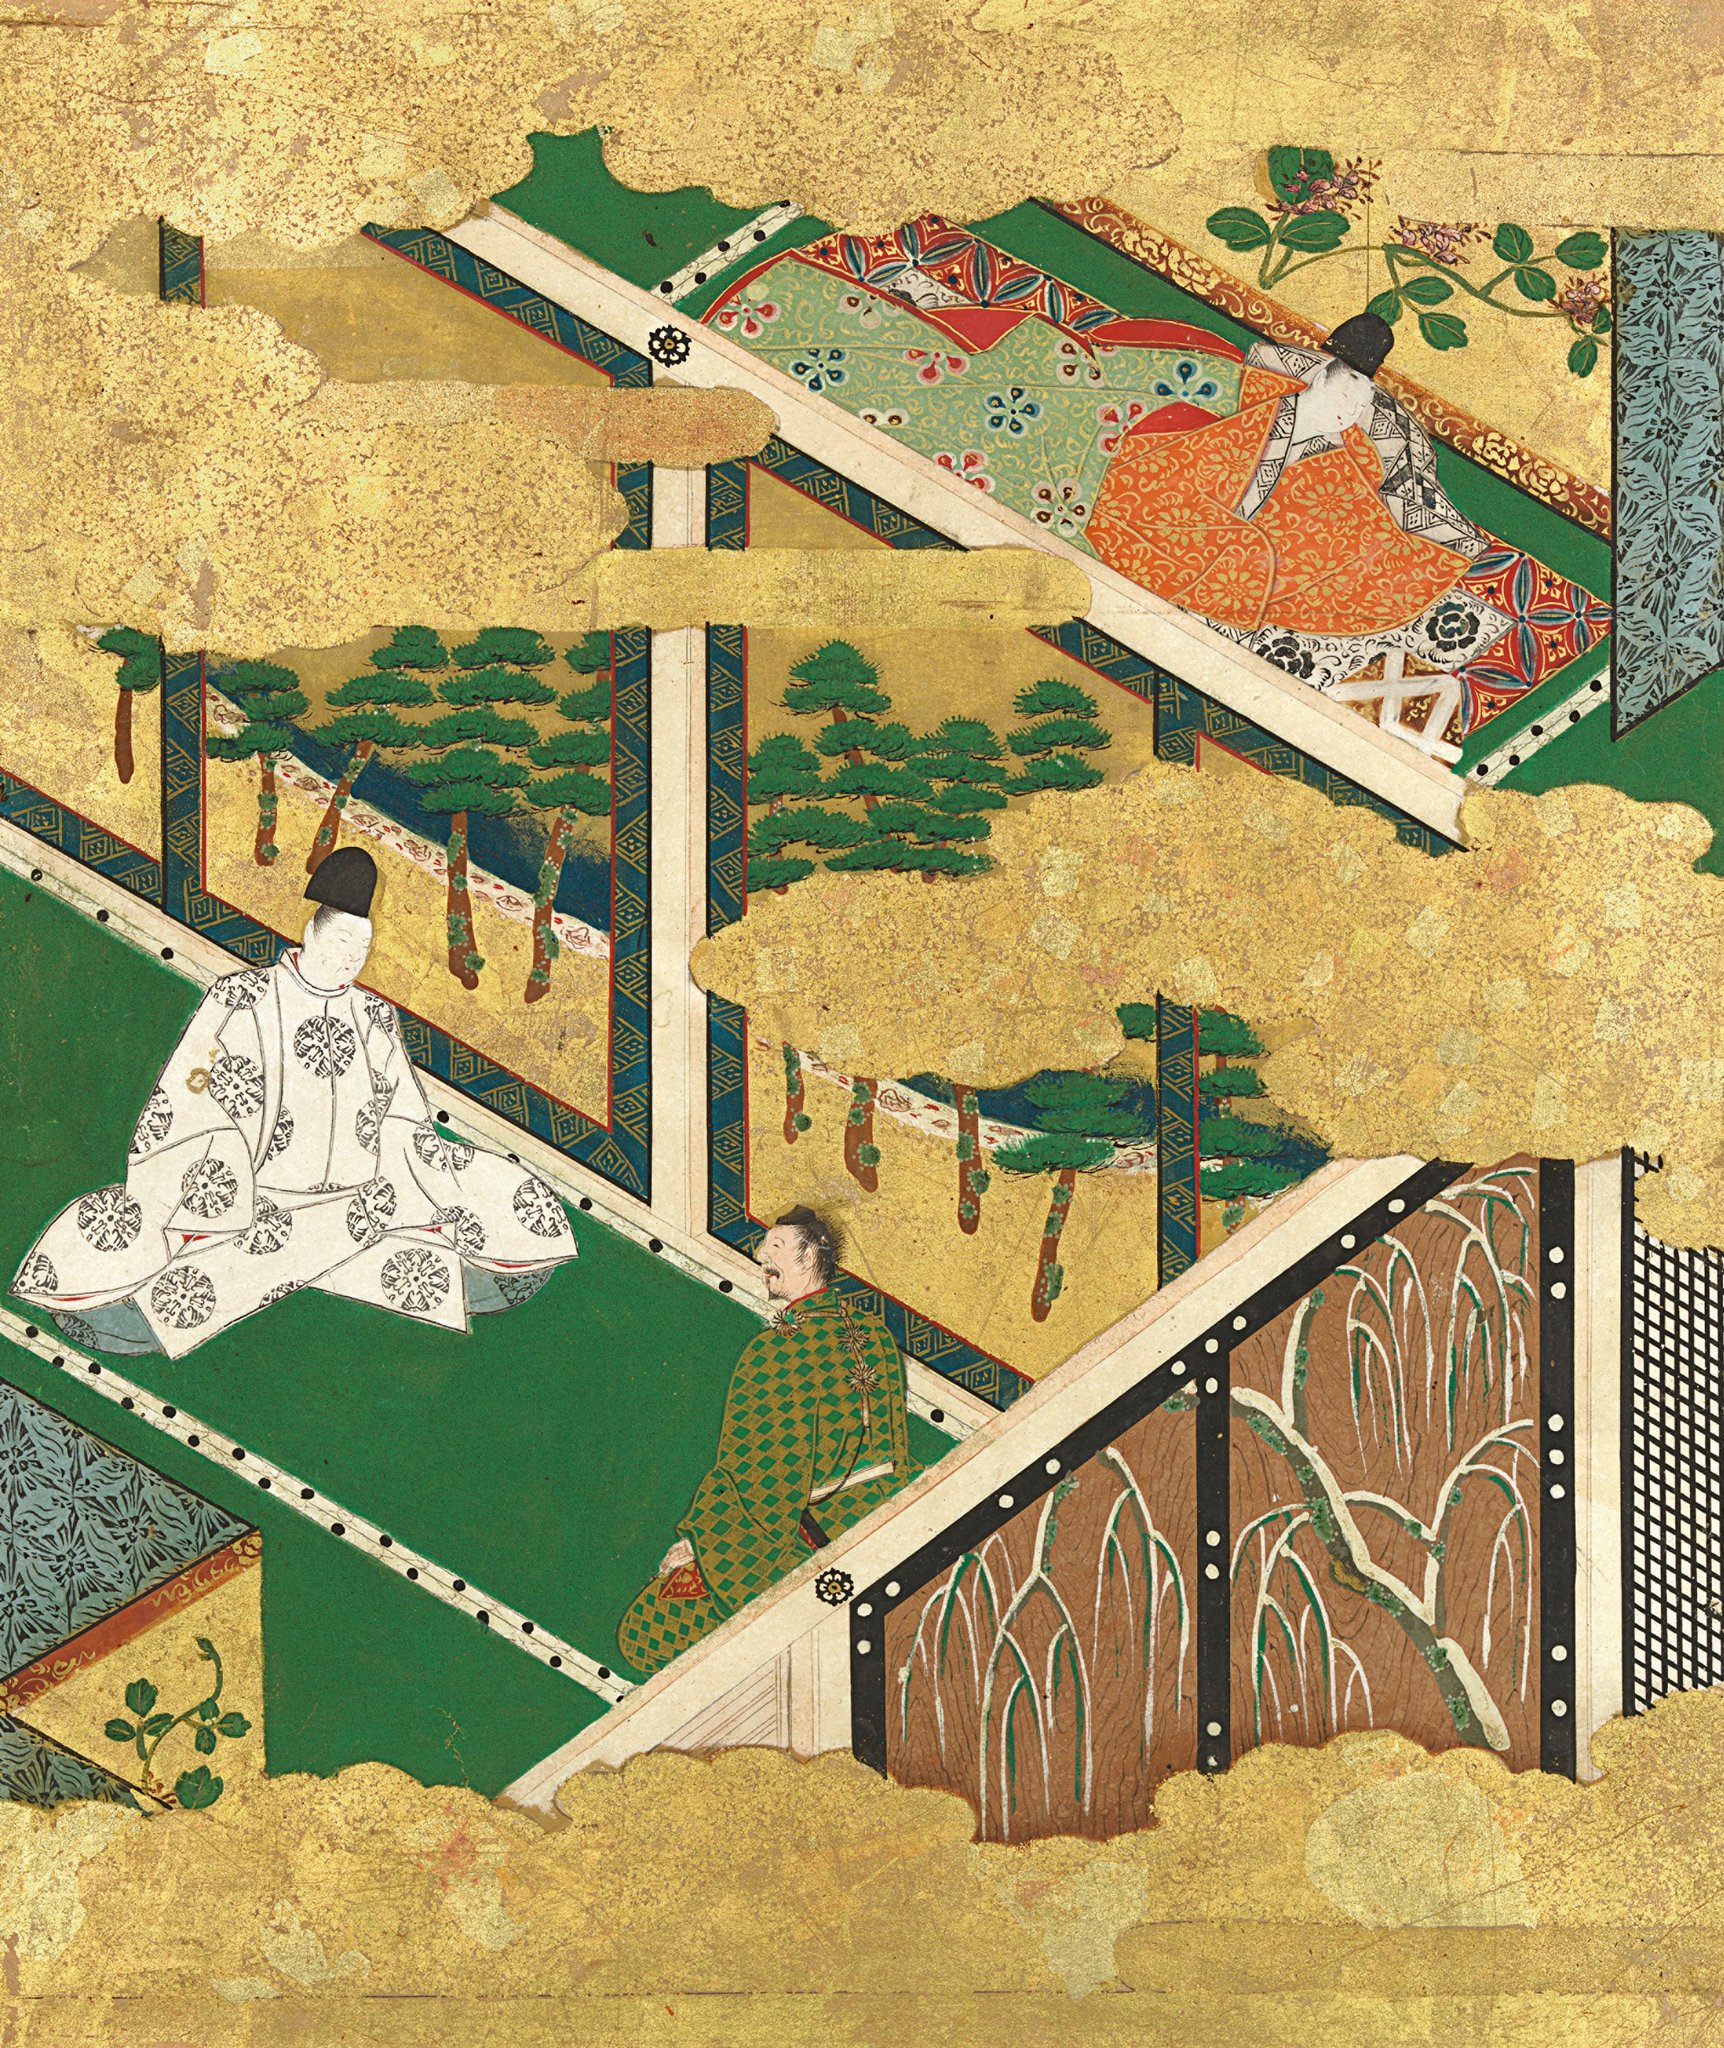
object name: hanging scroll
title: “The Oak Tree”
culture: japanese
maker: tosa mitsuyoshi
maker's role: artist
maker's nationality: japanese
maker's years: 1539-1613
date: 1567-1633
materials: gold, ink, paper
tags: men